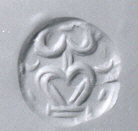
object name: stamp seal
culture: sasanian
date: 401-700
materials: stone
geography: iran